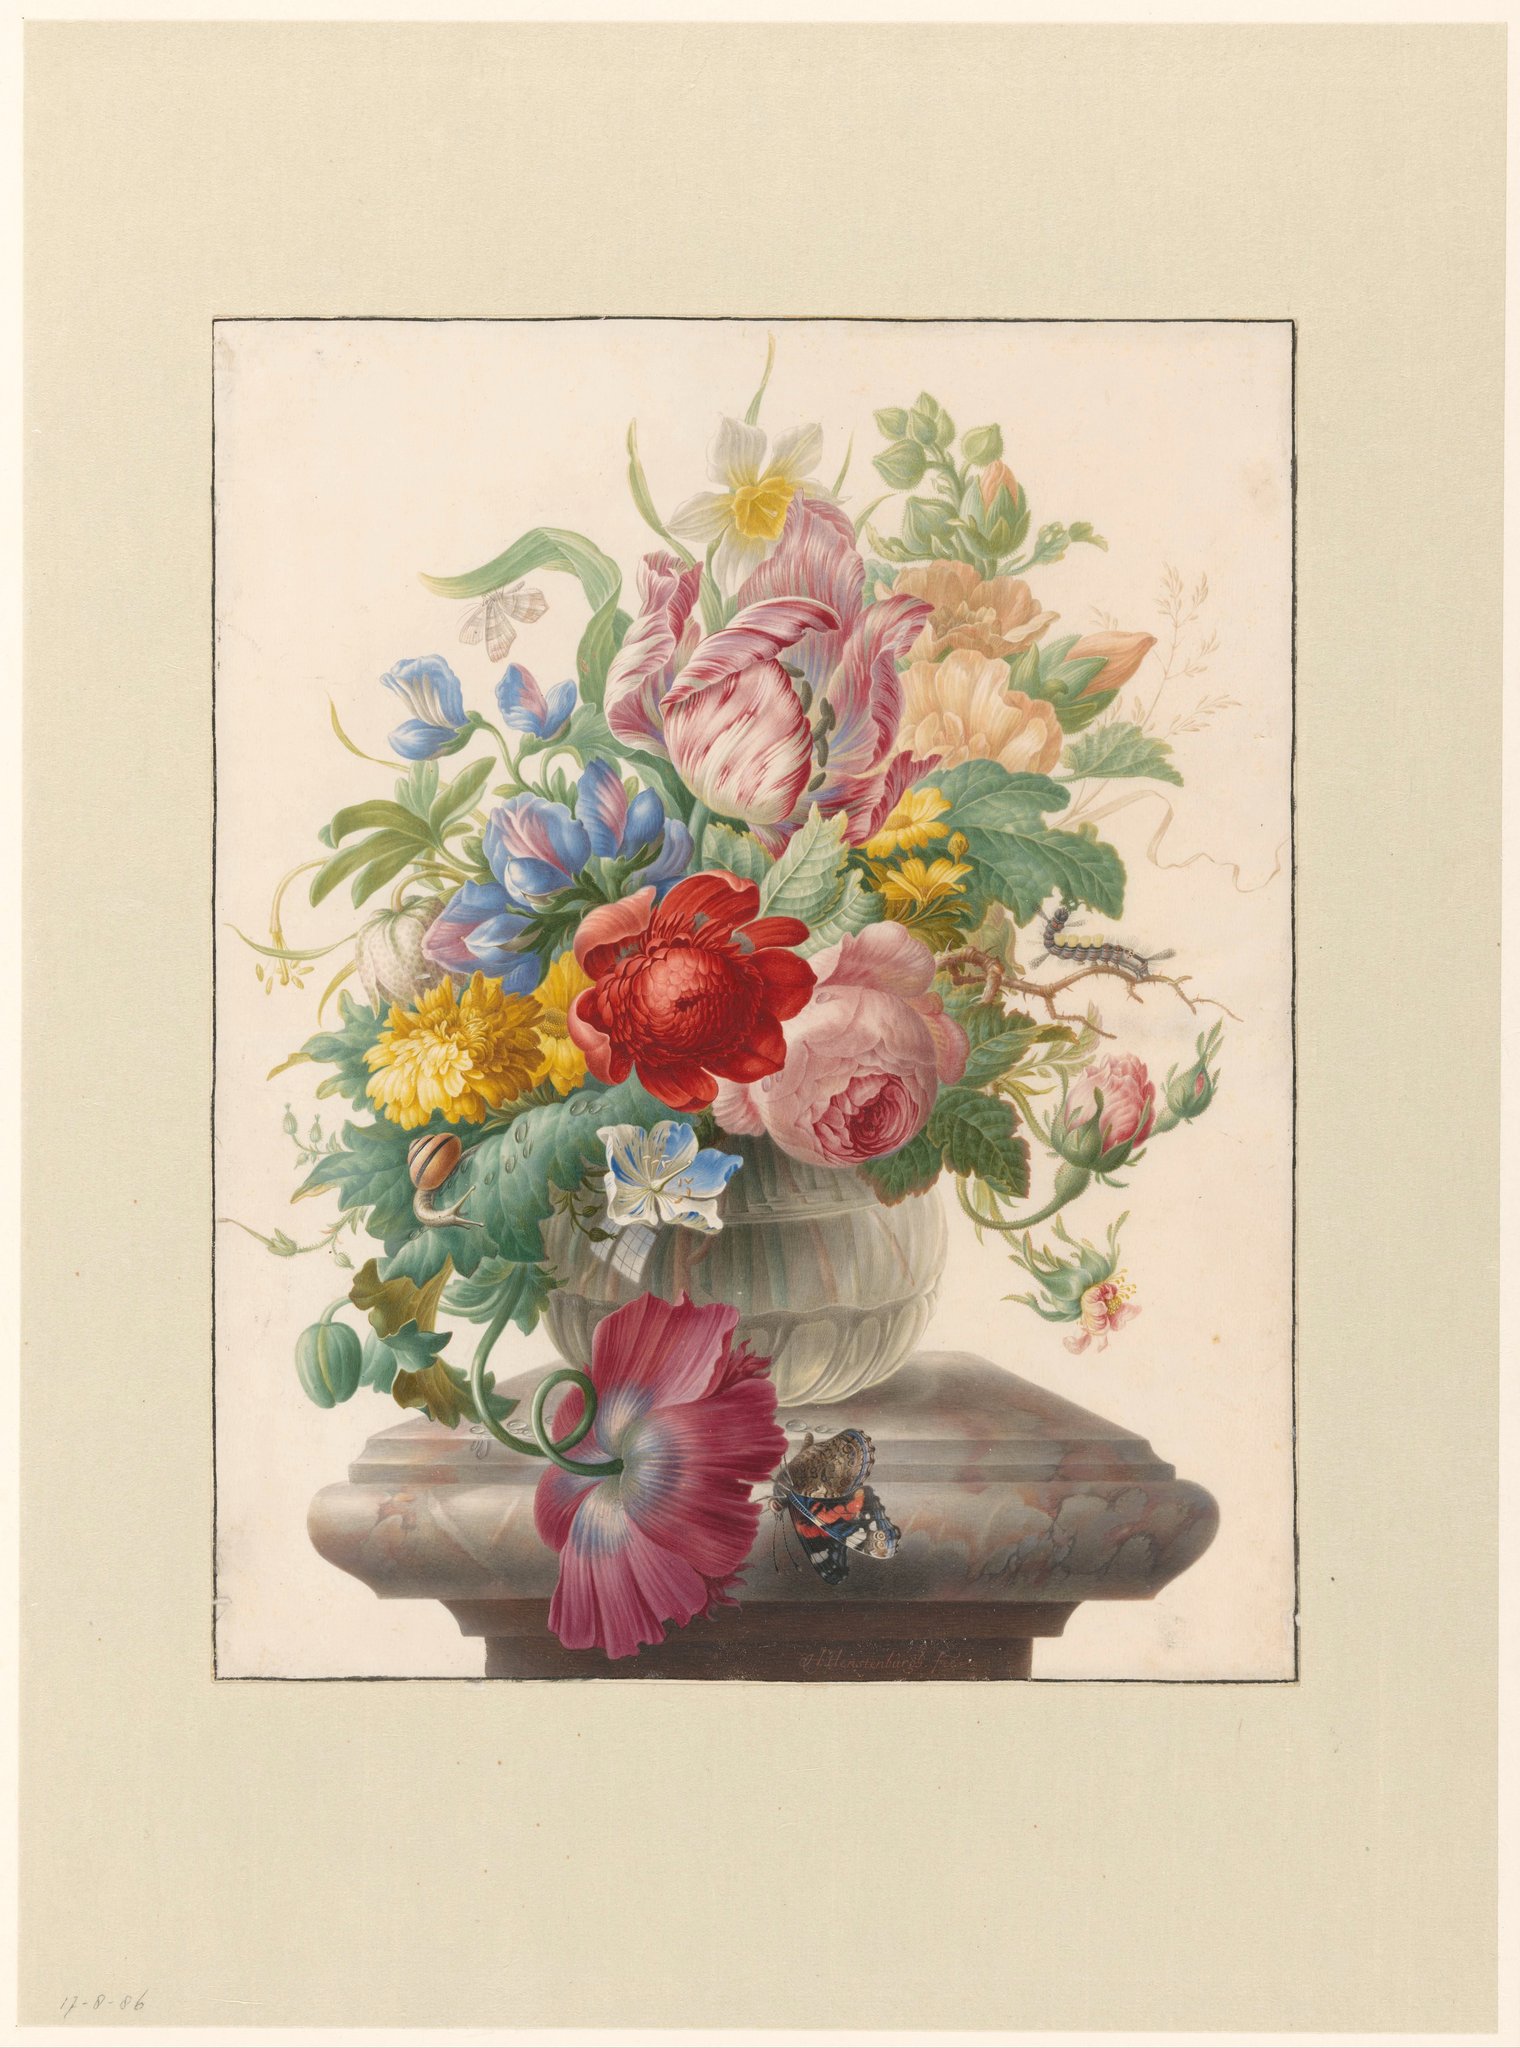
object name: drawing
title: Flowers in a Glass Vase with a Butterfly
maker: herman henstenburgh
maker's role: draughtsman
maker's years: 1667-1726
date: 1700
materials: paint, gouache, parchment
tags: 'vanitas' still life, flowers in a vase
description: Herman Henstenburgh is known for the pure and powerful colours with which he rendered his remarkably soft, even rarefied, floral still lifes. He often painted them on costly parchment, such as here. In spite of his fame and the expensive materials he used, one wonders whether he actually made a living from his art: he also worked as a pastry baker until his death.